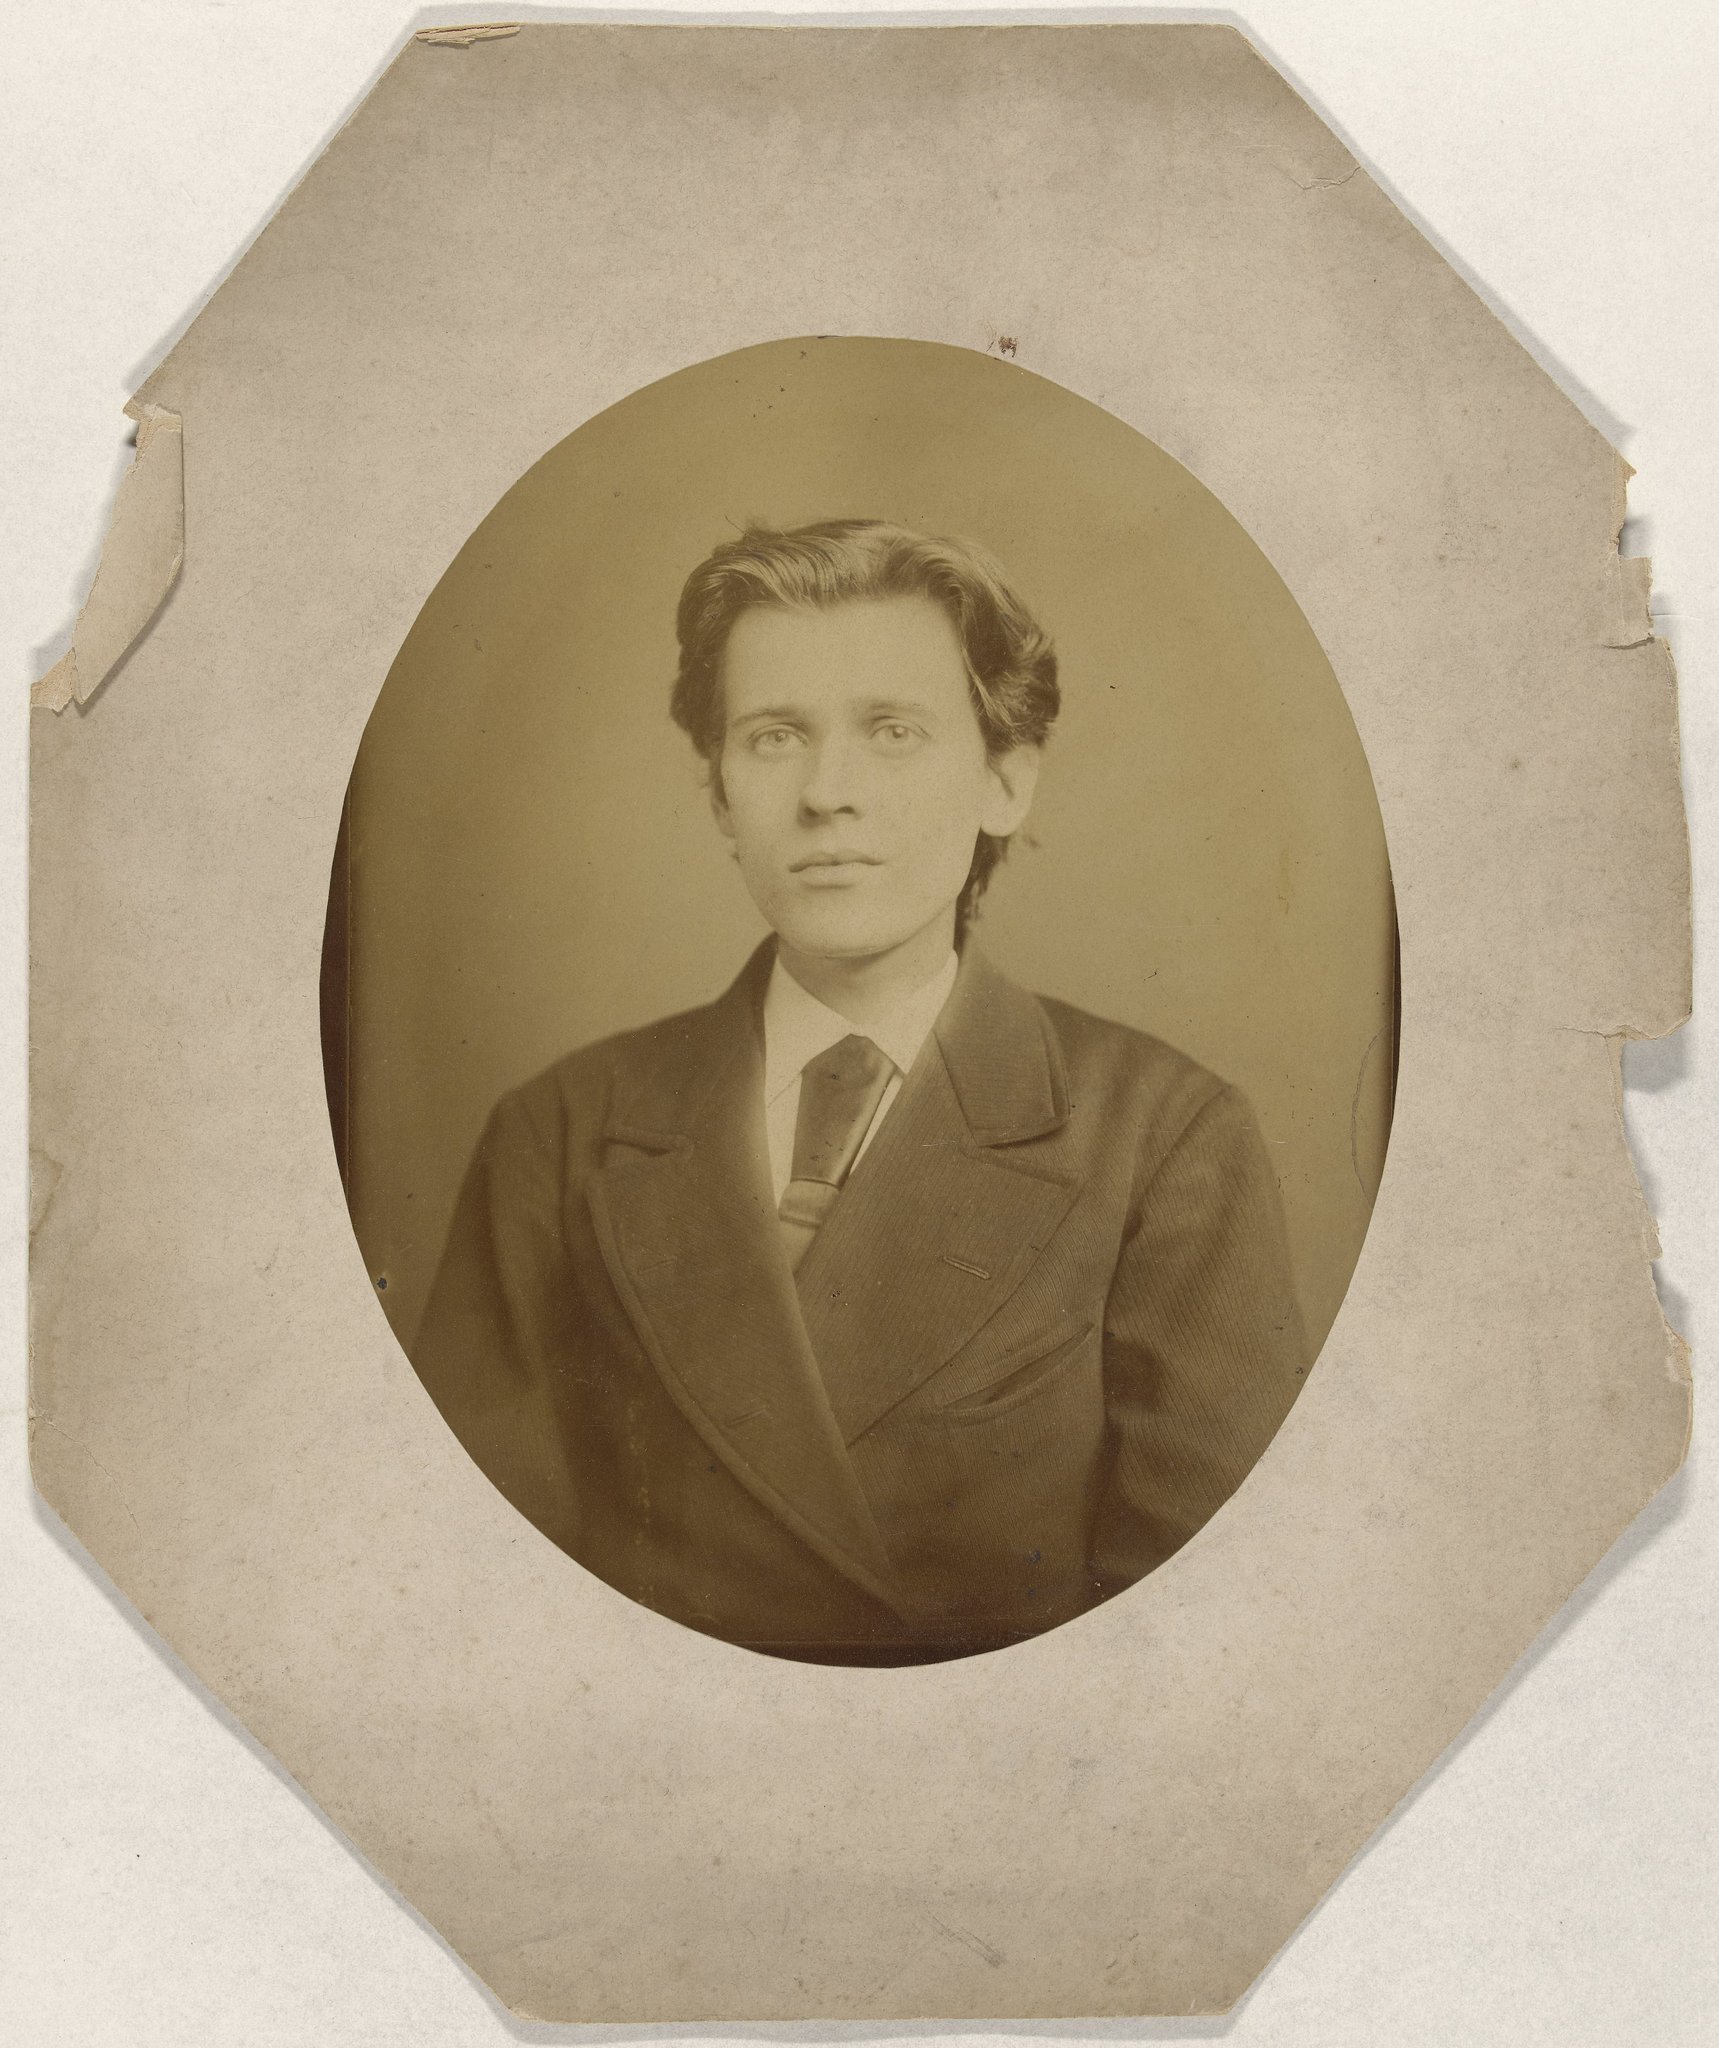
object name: photograph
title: Portret van een man in pak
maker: Anonymous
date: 1870-1900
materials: cardboard, photographic support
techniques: albumen print